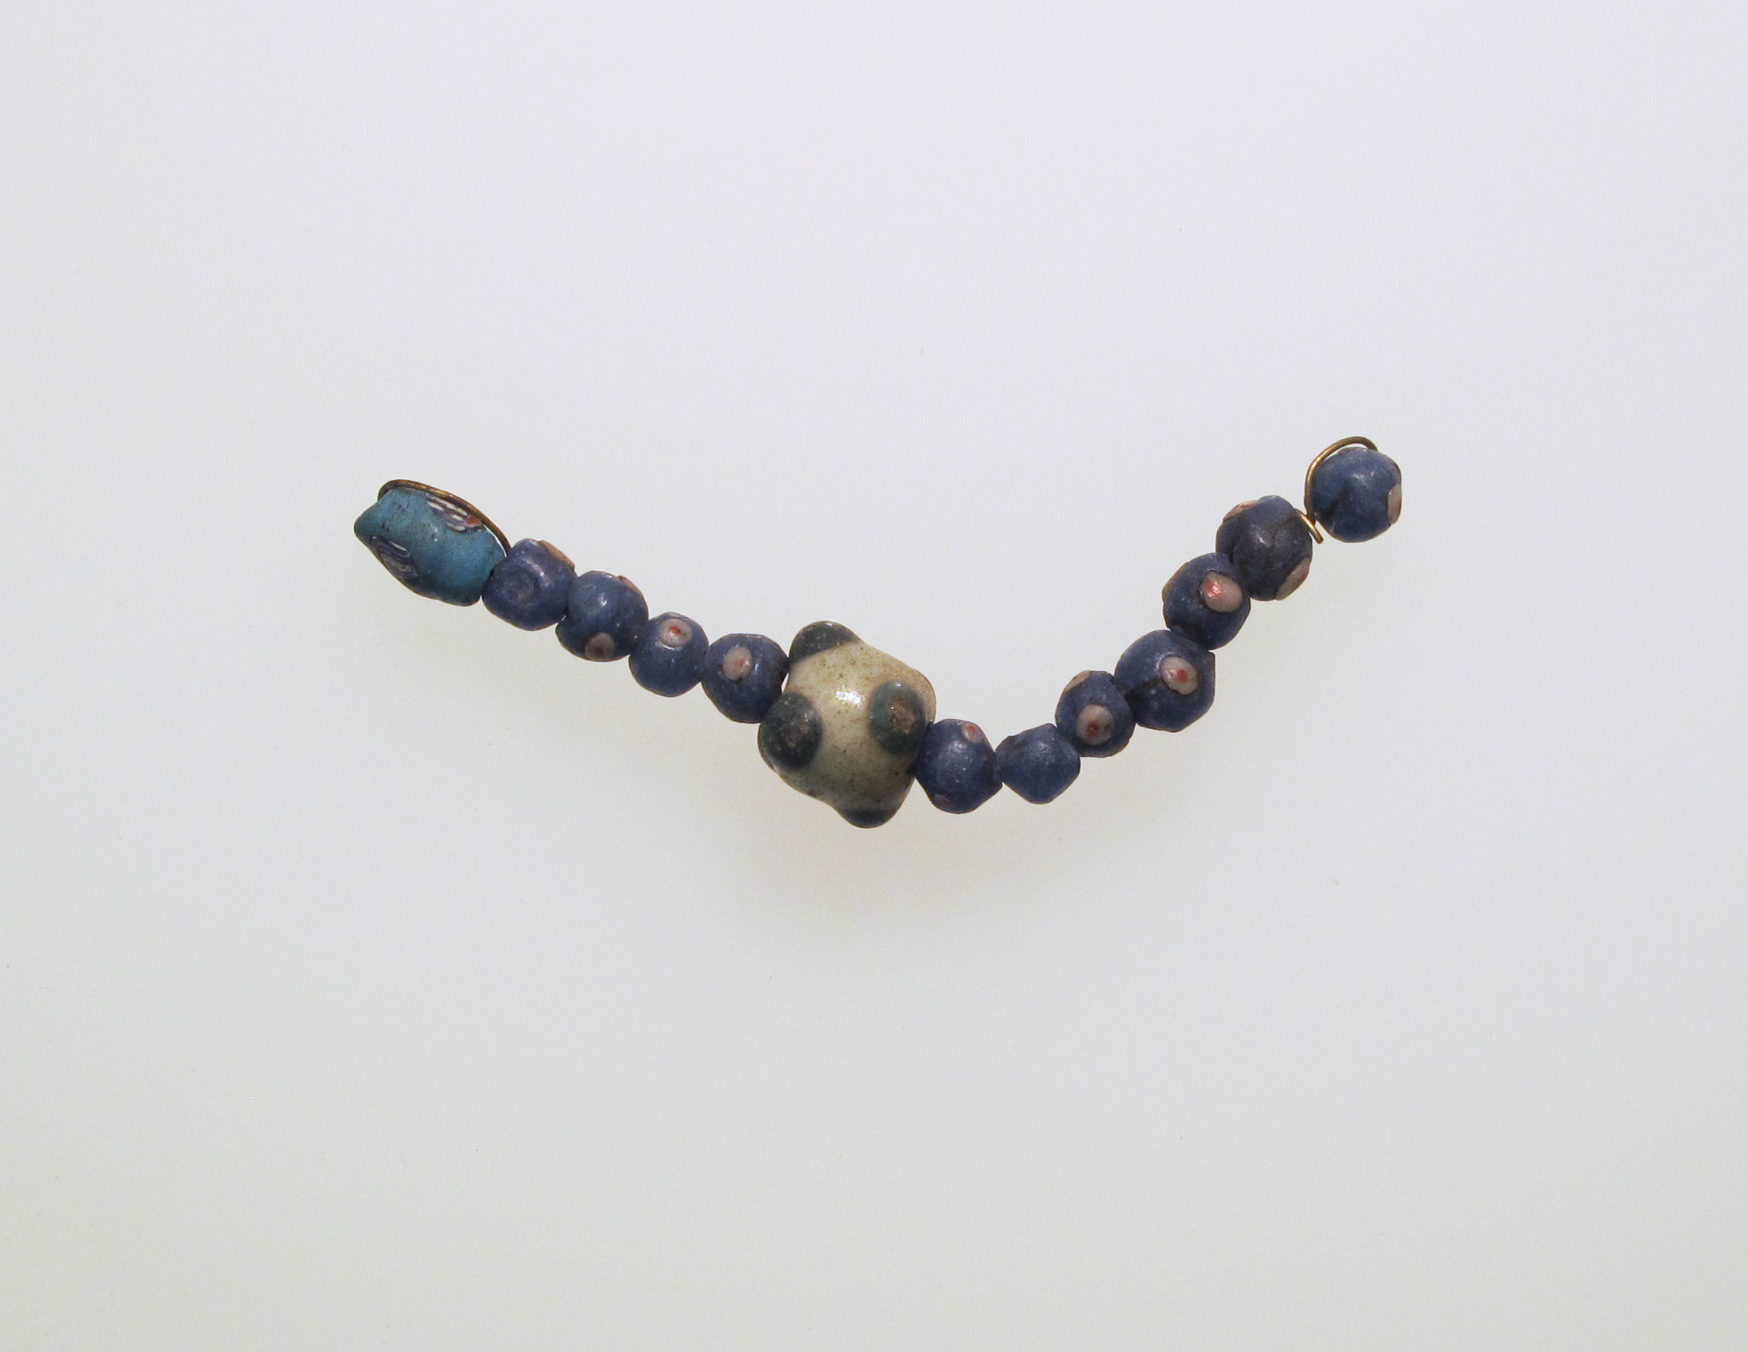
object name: bead, 14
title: Glass beads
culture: roman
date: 301-400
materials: glass